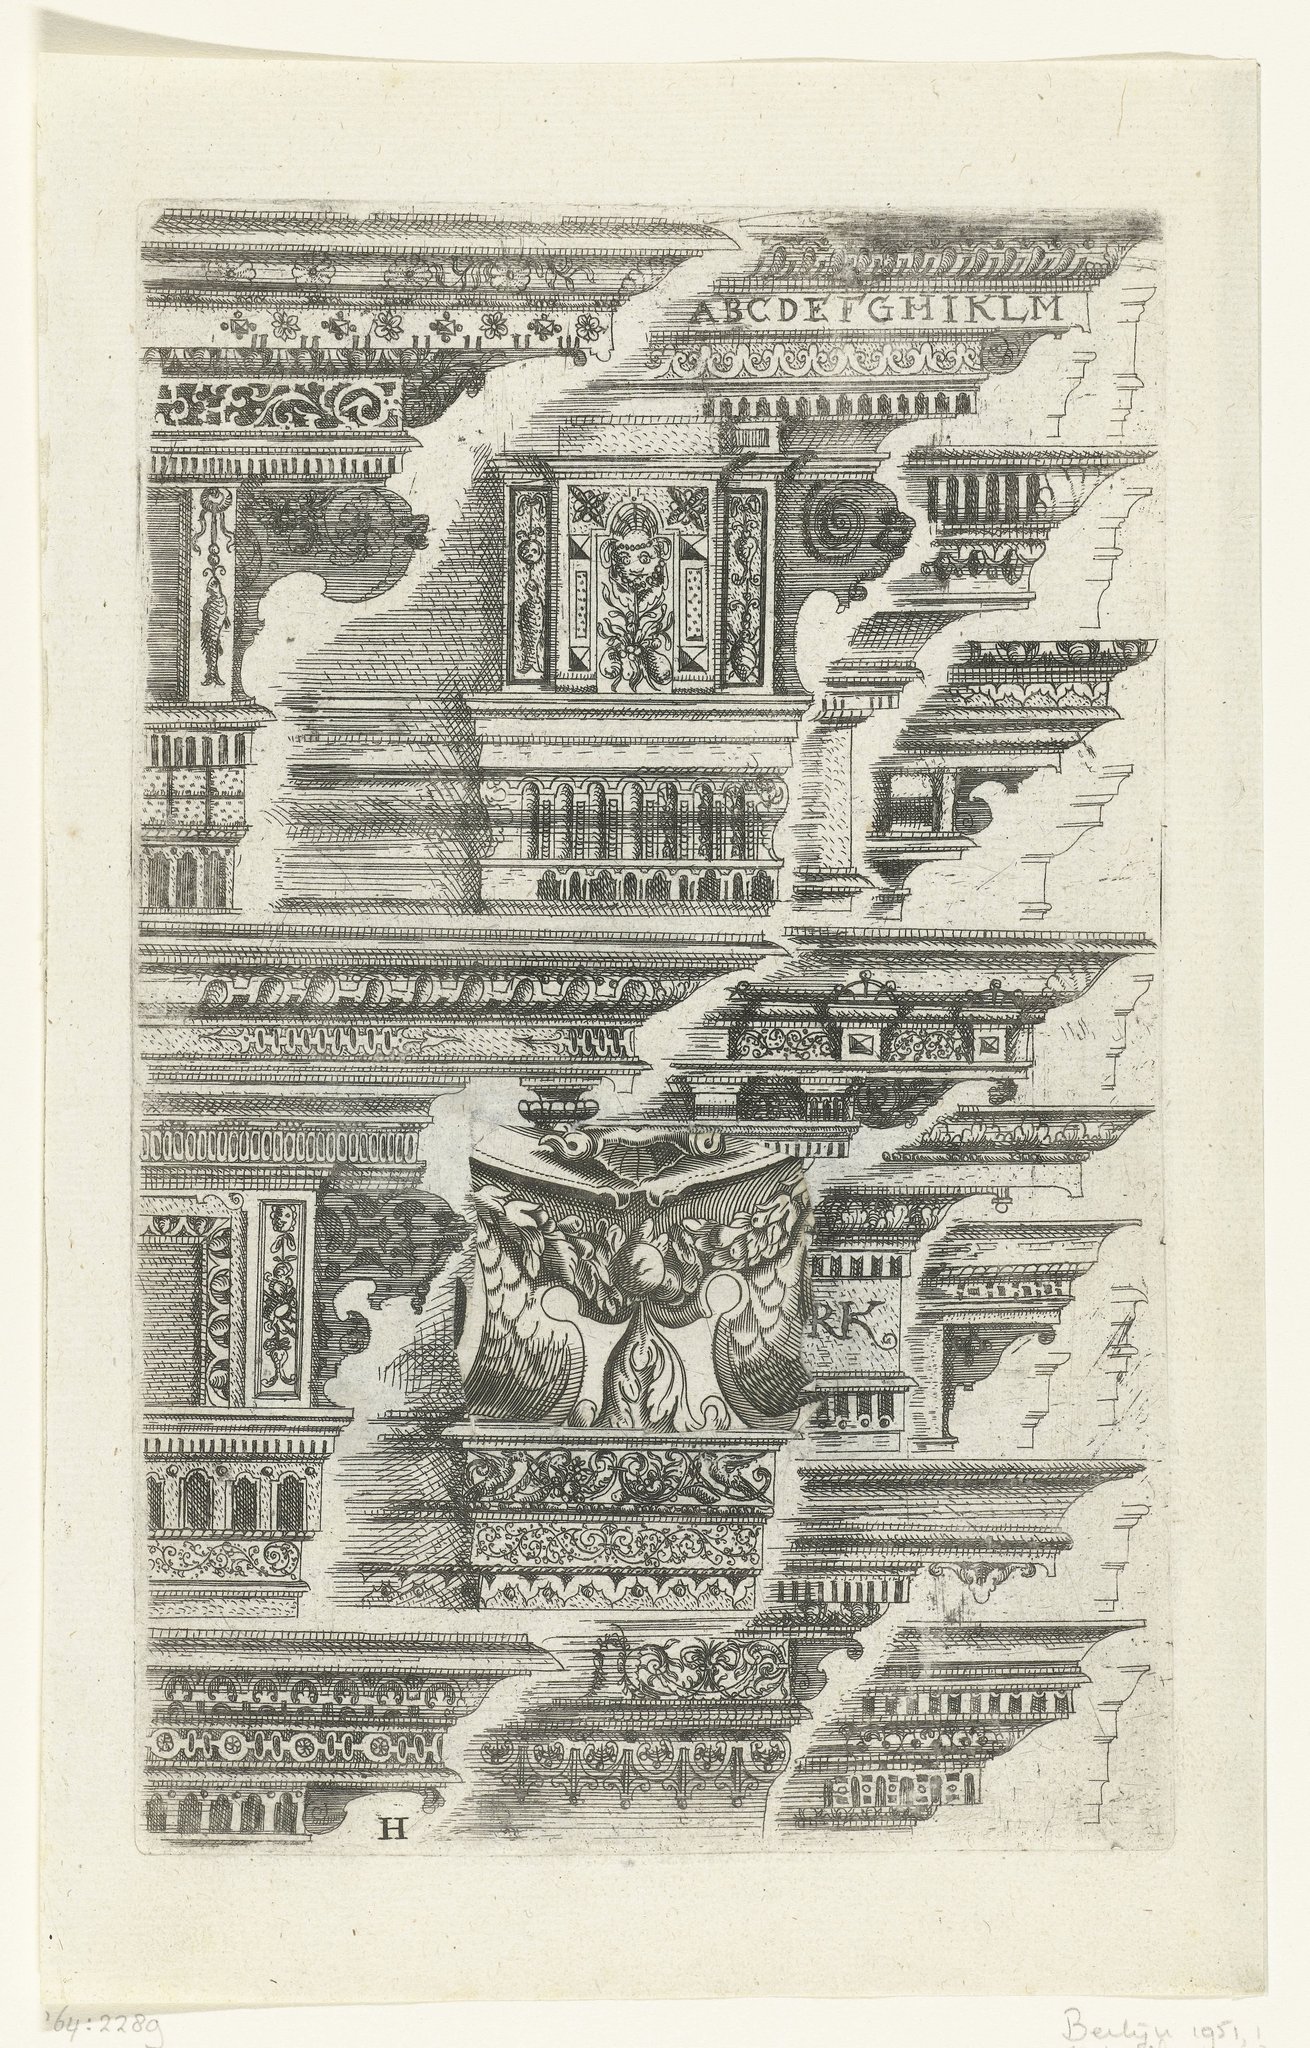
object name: ornament print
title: Livre d' Architecture contenant plusieurs beaux ornementz (...)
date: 1622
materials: paper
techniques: etching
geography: germany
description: Hoofdgestellen met fantasiedecoraties. Blad H uit tweede editie van serie, bestaande uit 24 bladen.